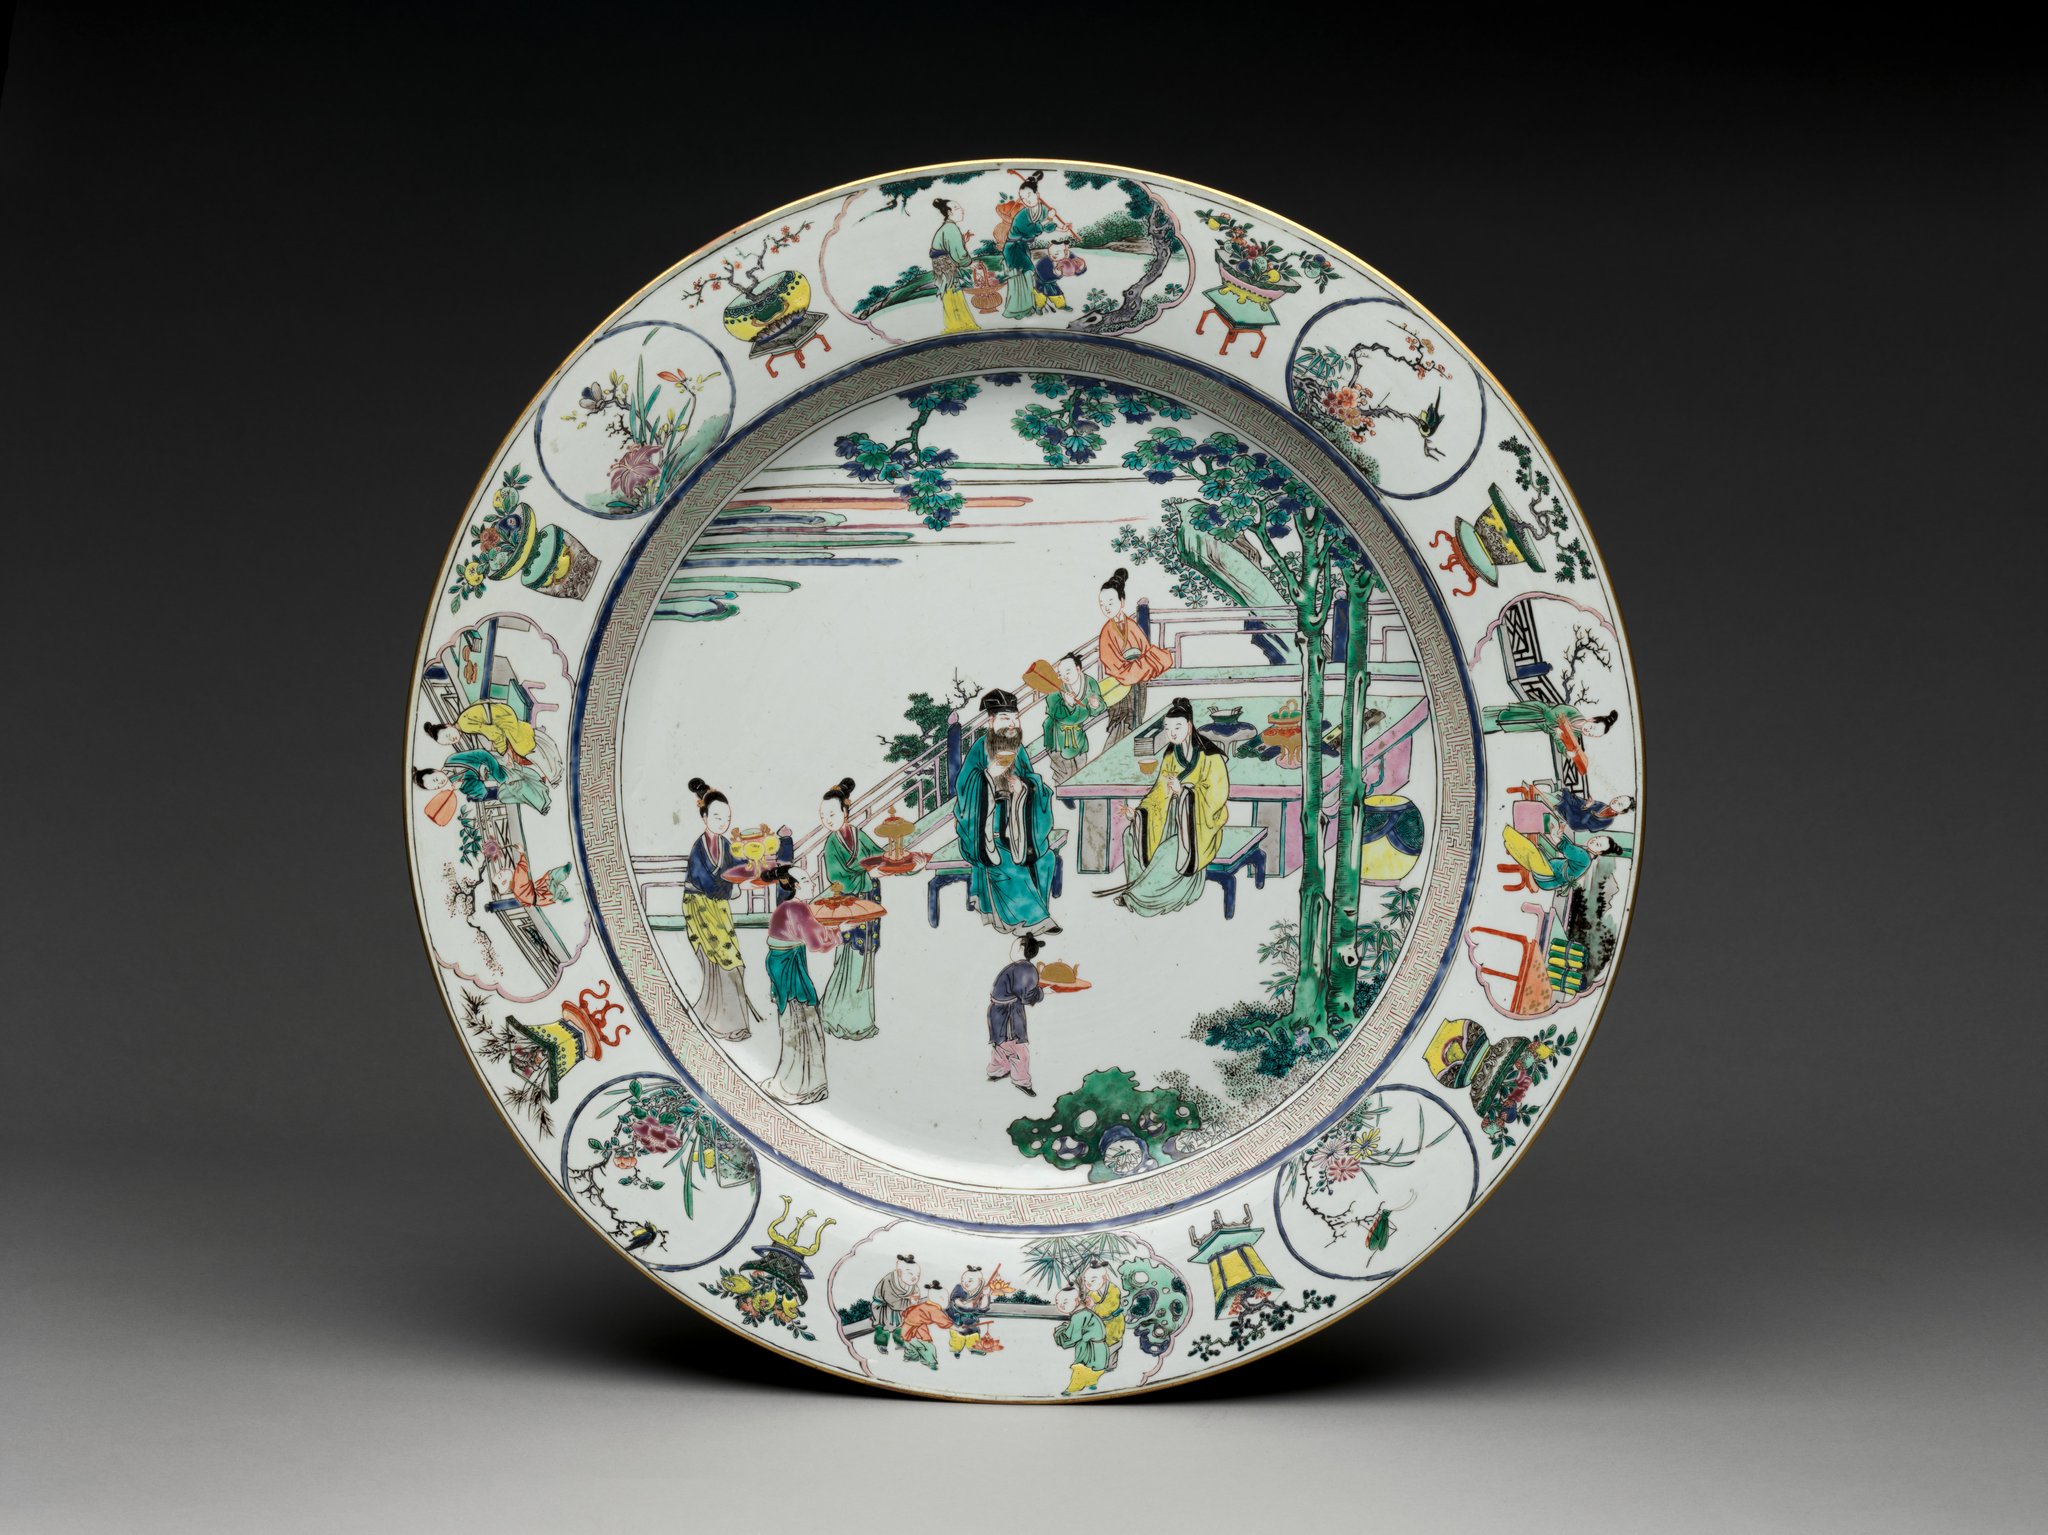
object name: plate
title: Plate with Scene of Offering Tribute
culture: chinese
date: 1701-1733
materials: biscuit, enamel, porcelain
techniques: painting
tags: men,women,trees